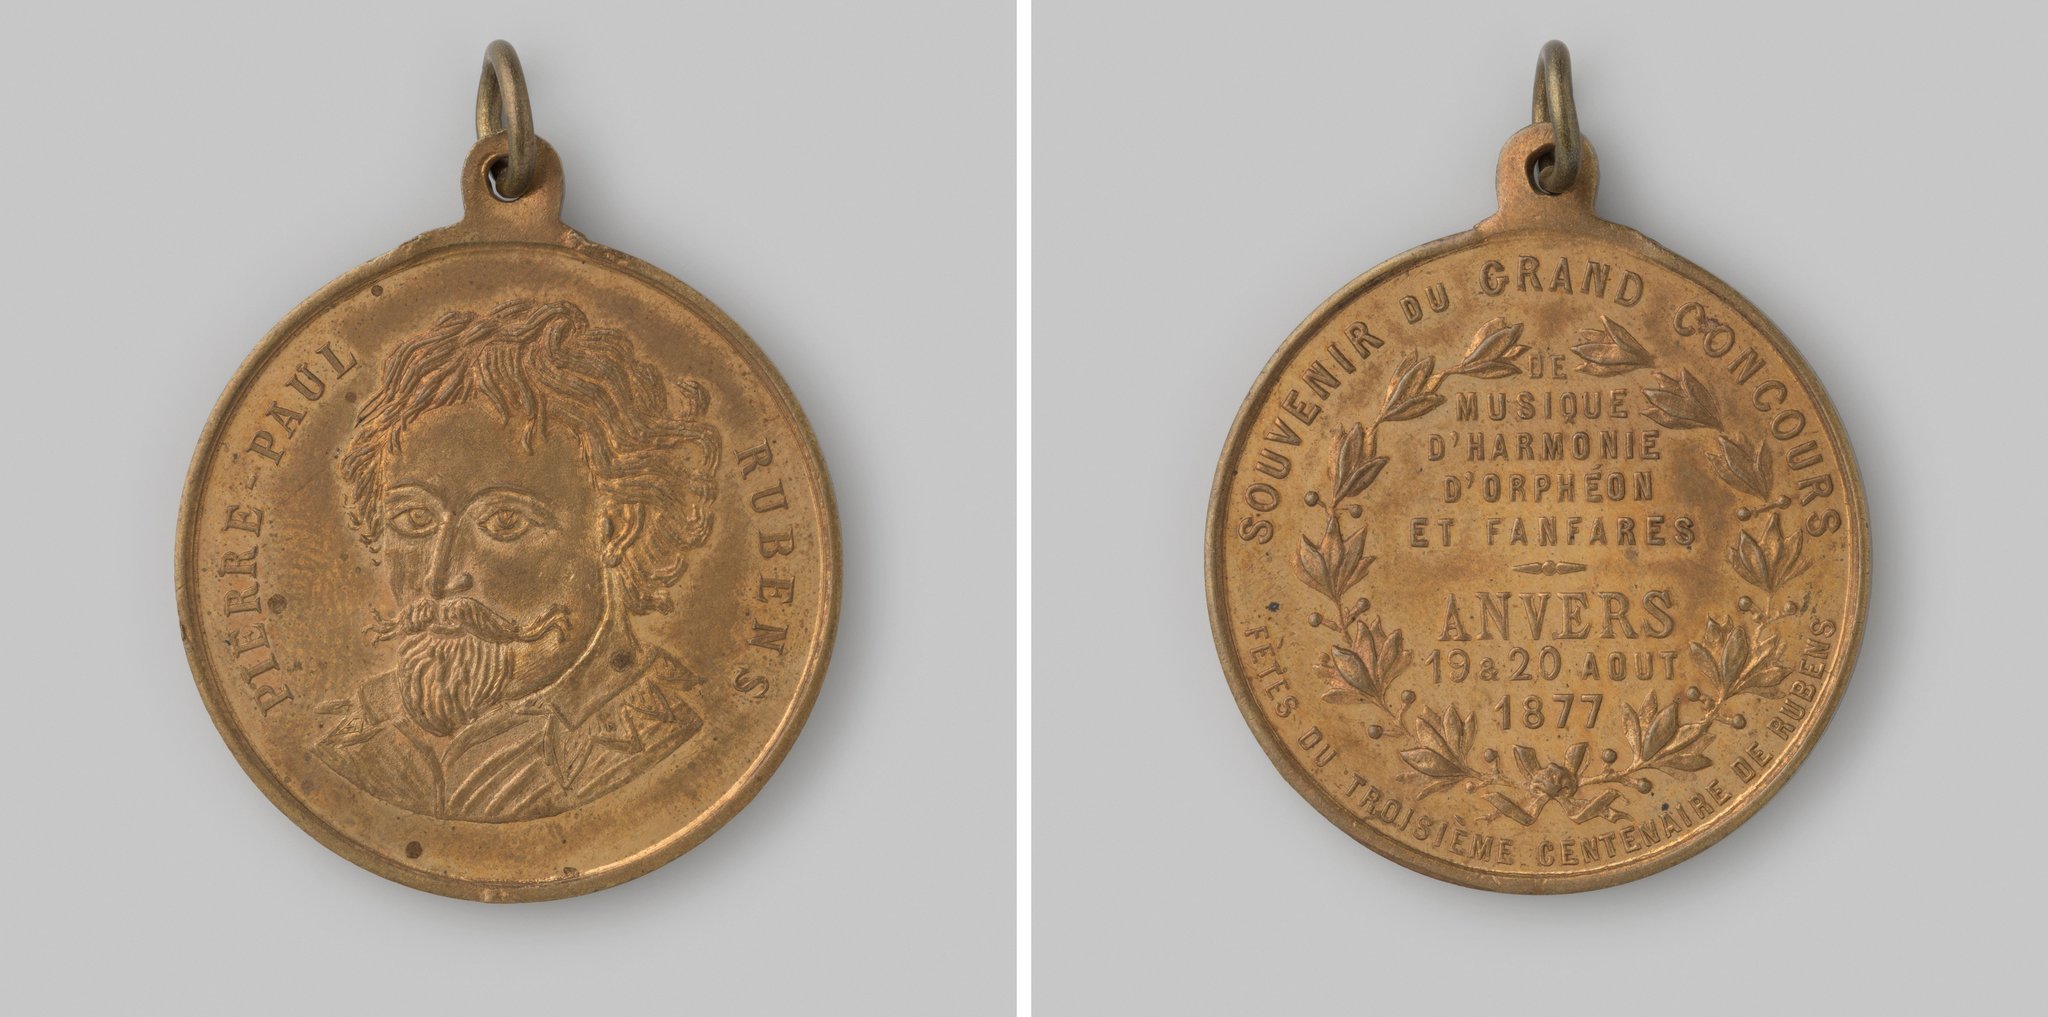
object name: history medal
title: Aandenken aan het muziekconcours te Antwerpen bij de driehonderdste geboortedag van Rubens 1877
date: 1877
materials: brass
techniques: striking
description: Messing penning met oog en draagring, op de voorzijde het borstbeeld van Rubens half naar links, met omschrift, op de keerzijde acht regels tekst tussen samengestrikte lauwertakken, met omschrift.